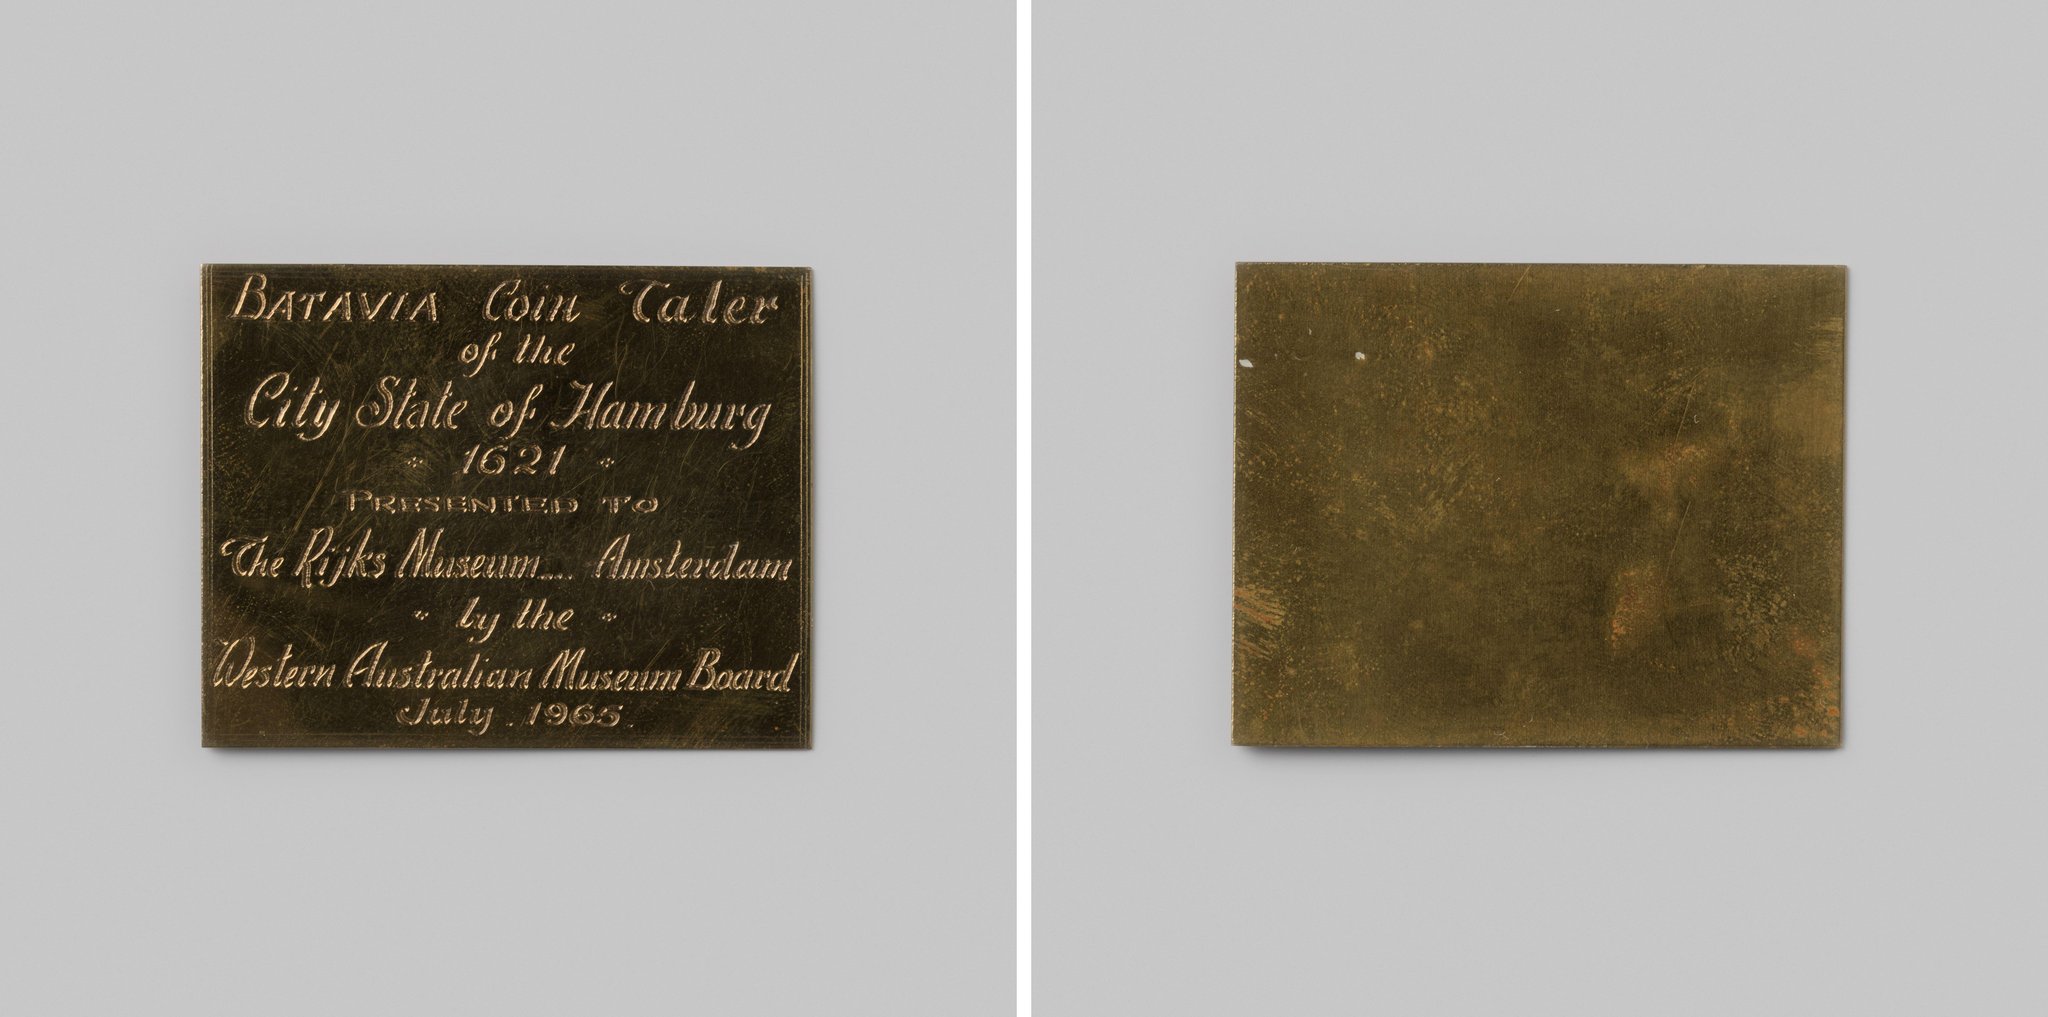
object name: commemorative plaque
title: Kleine gedenkplaat van koper, horend bij een taler uit Hamburg, afkomstig van het wrak van het VOC-schip Batavia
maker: Anonymous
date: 1965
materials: copper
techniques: engraving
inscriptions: date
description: Koperen plaatje met opschrift: Batavia coin taler / of the / City of Hamburg / 1621 / presented to / the Rijksmuseum Amsterdam / by the / Western Australian Museum Board / July 1965.